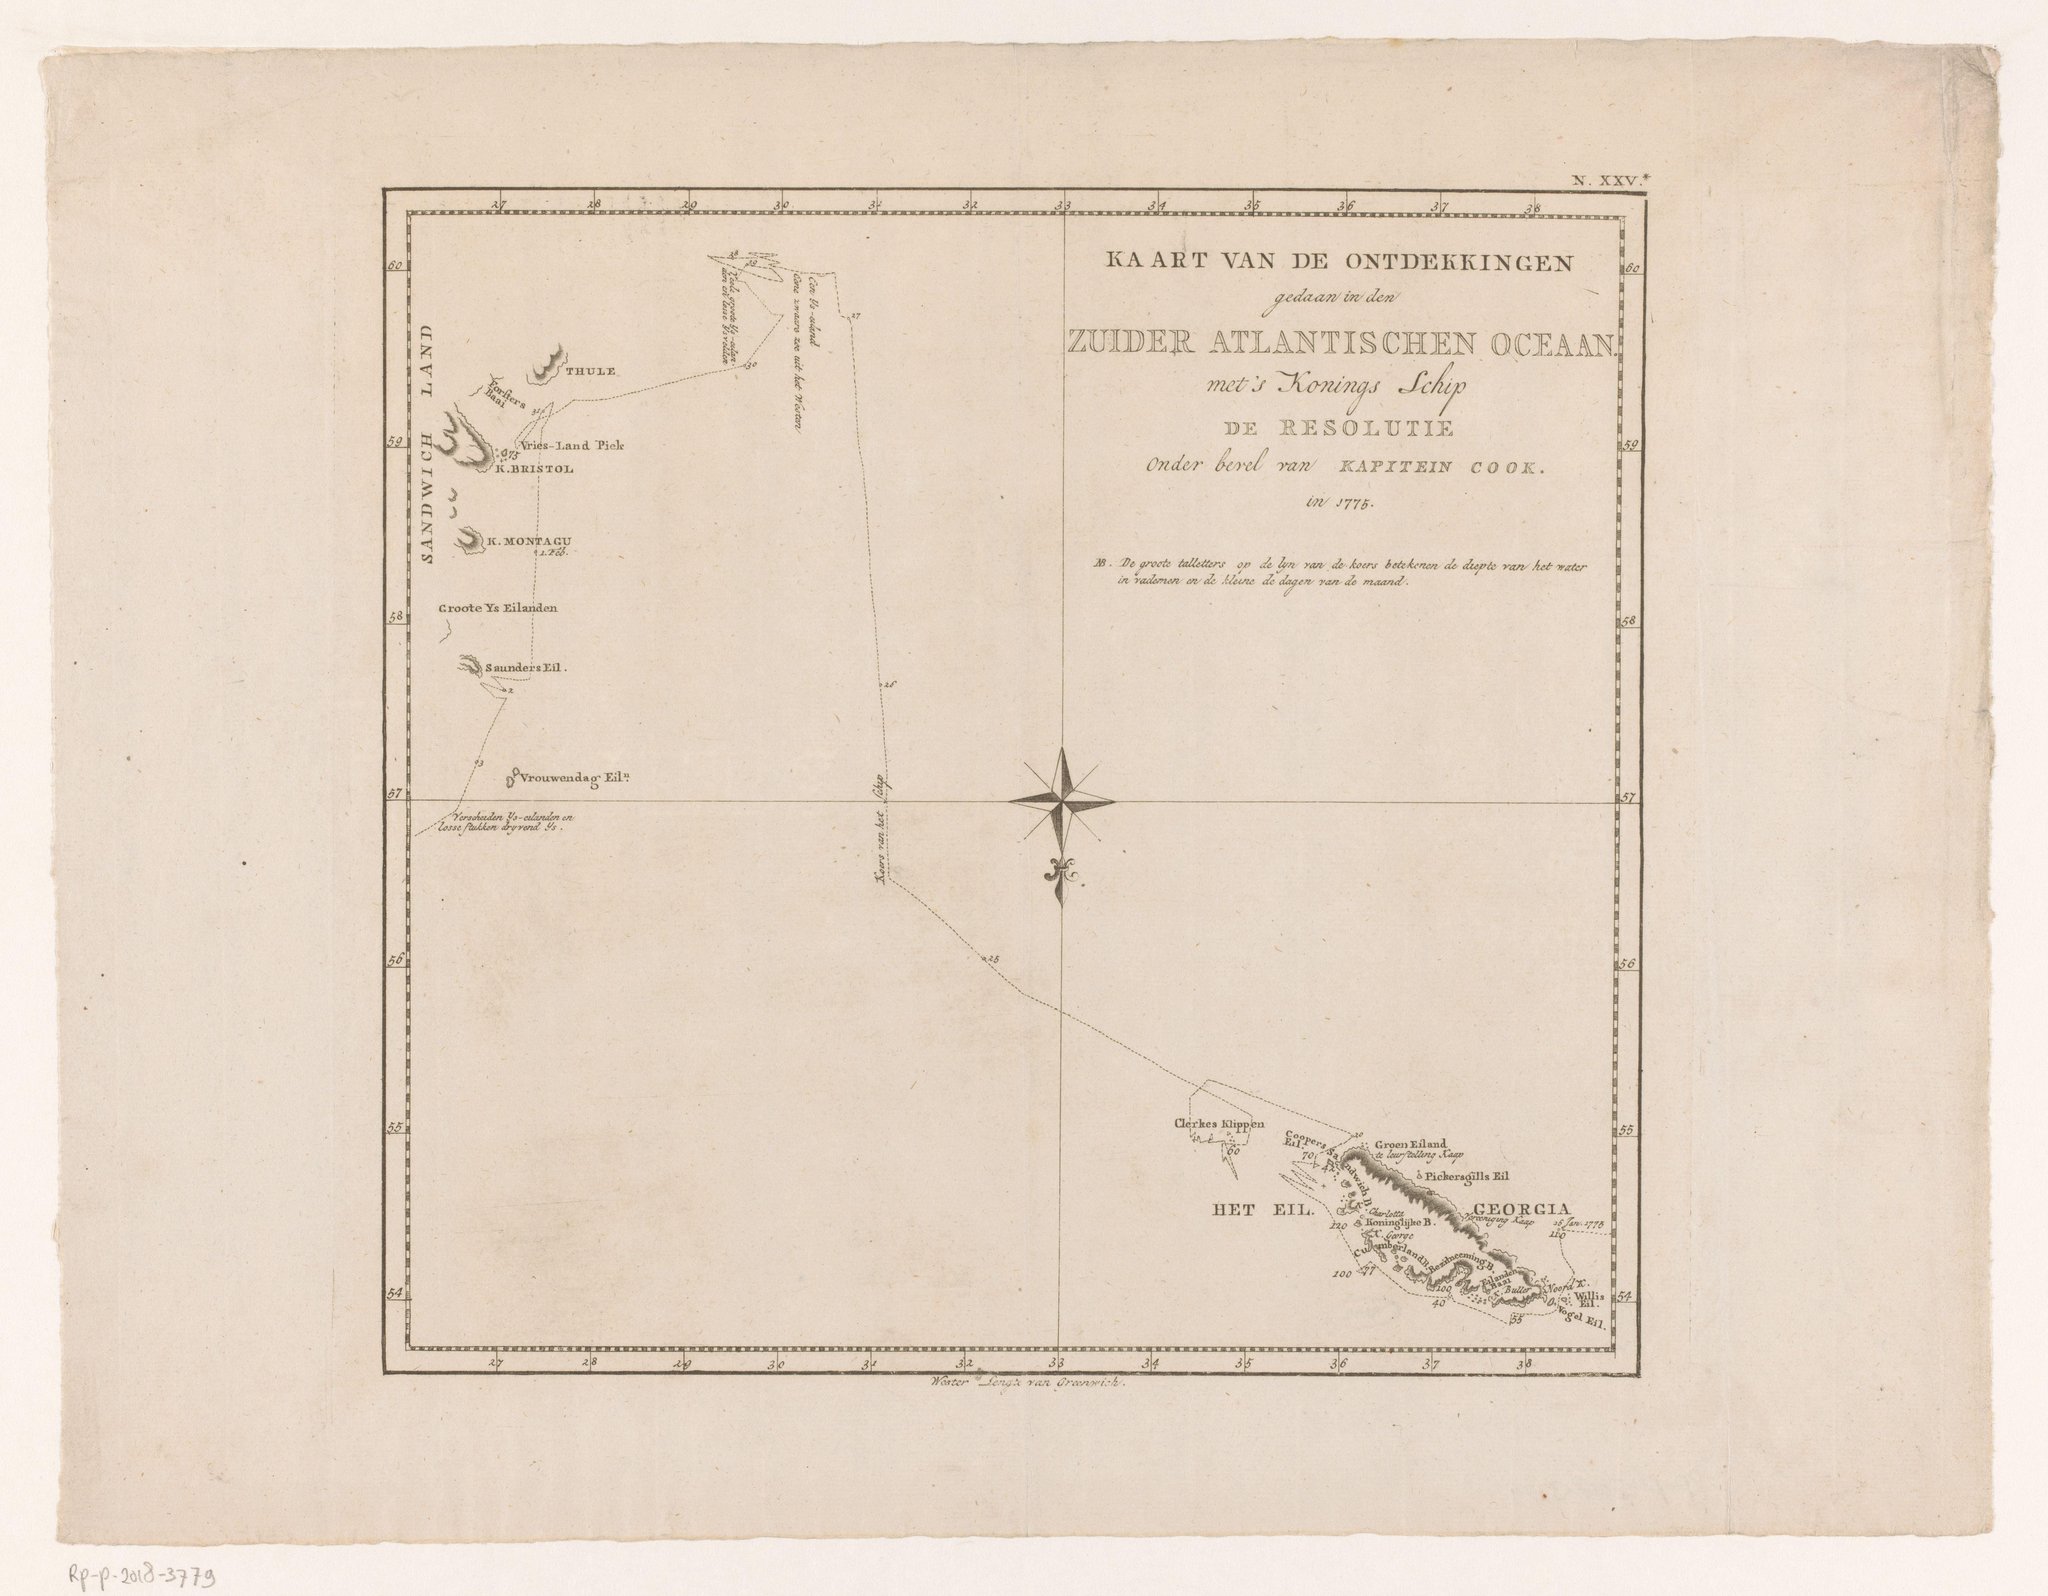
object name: map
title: Kaart van Zuid-Georgia en de Zuidelijke Sandwicheilanden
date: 1800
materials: paper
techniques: etching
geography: the hague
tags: island, maps, atlases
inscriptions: collector's mark: Lugt 2228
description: Prent uit: Cook, James. Reize rondom de Waereld (...) met kaarten en plaaten. [Vertaald uit het Engels door] Jan David Pasteur. Leiden: Honkoop, Amsterdam: Allart, Den Haag: Van Cleef, 1800, dl. 7, p. 162.